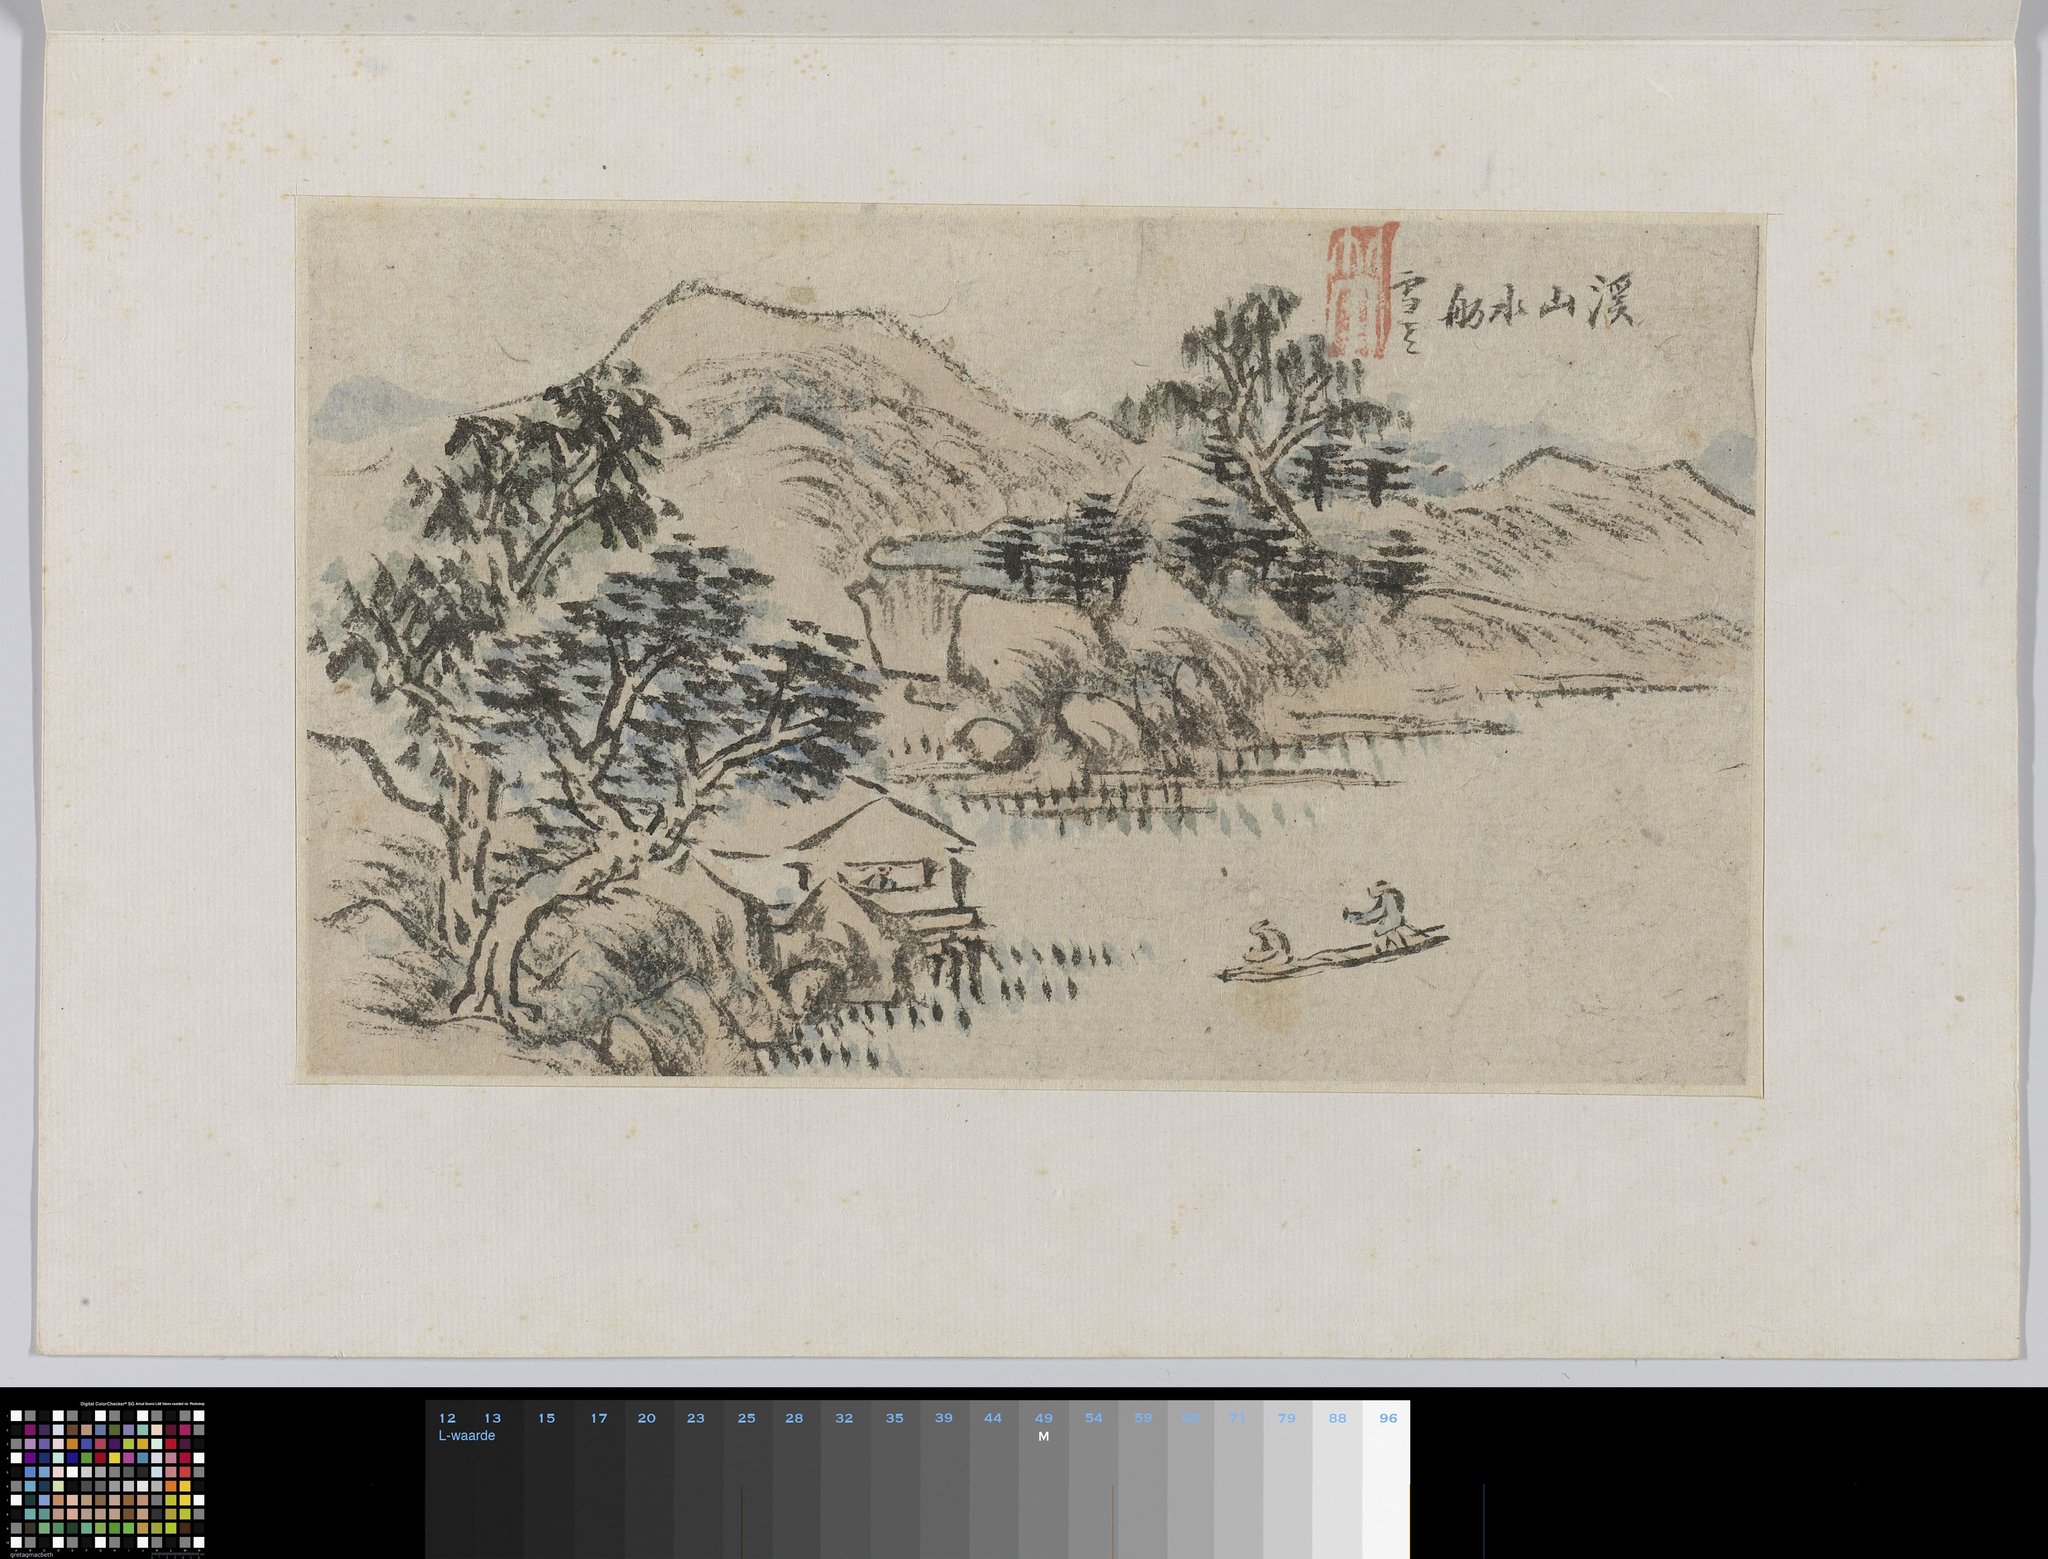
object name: album leaf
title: Landschap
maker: cheng men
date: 1850-1900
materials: ink, paper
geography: shexian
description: Albumblad met een landschap. Gesigneerd door Cheng Men, bekend als porseleinschilder in Jingdezhen.